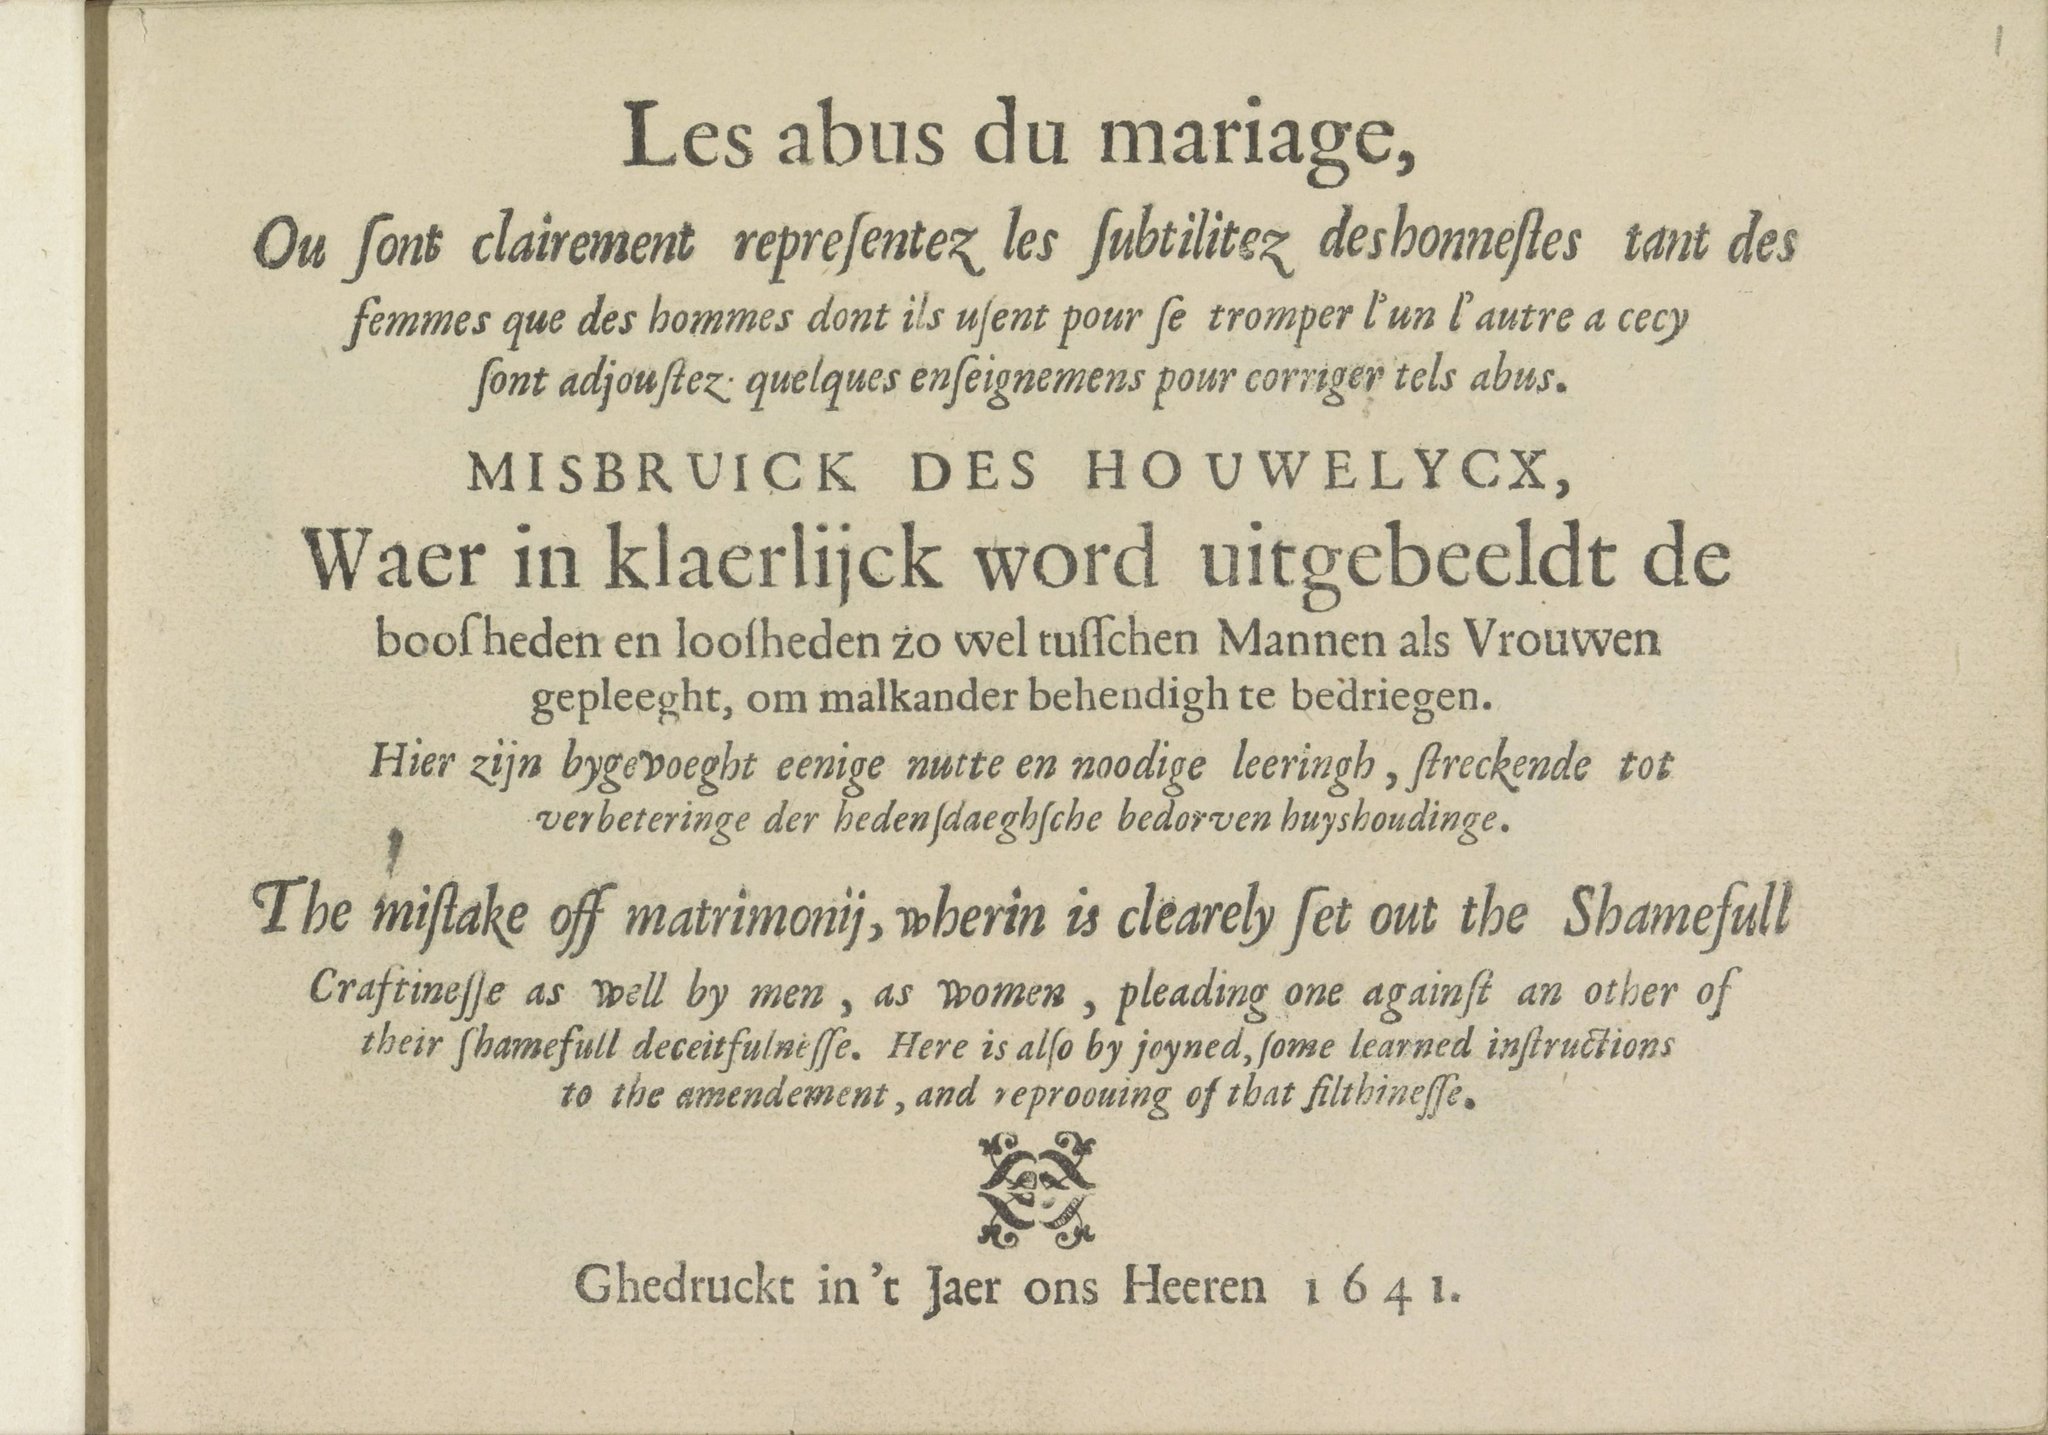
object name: titelblad, titelpagina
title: Titelpagina voor: Les abus du mariage / Misbruick des houwelycx / The mistake off matrimonij, 1641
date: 1641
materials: paper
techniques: letterpress printing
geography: amsterdam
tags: title-page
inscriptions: collector's mark: ‘RIJKS / MUSM’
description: Deze titelpagina maakt deel uit van een album.